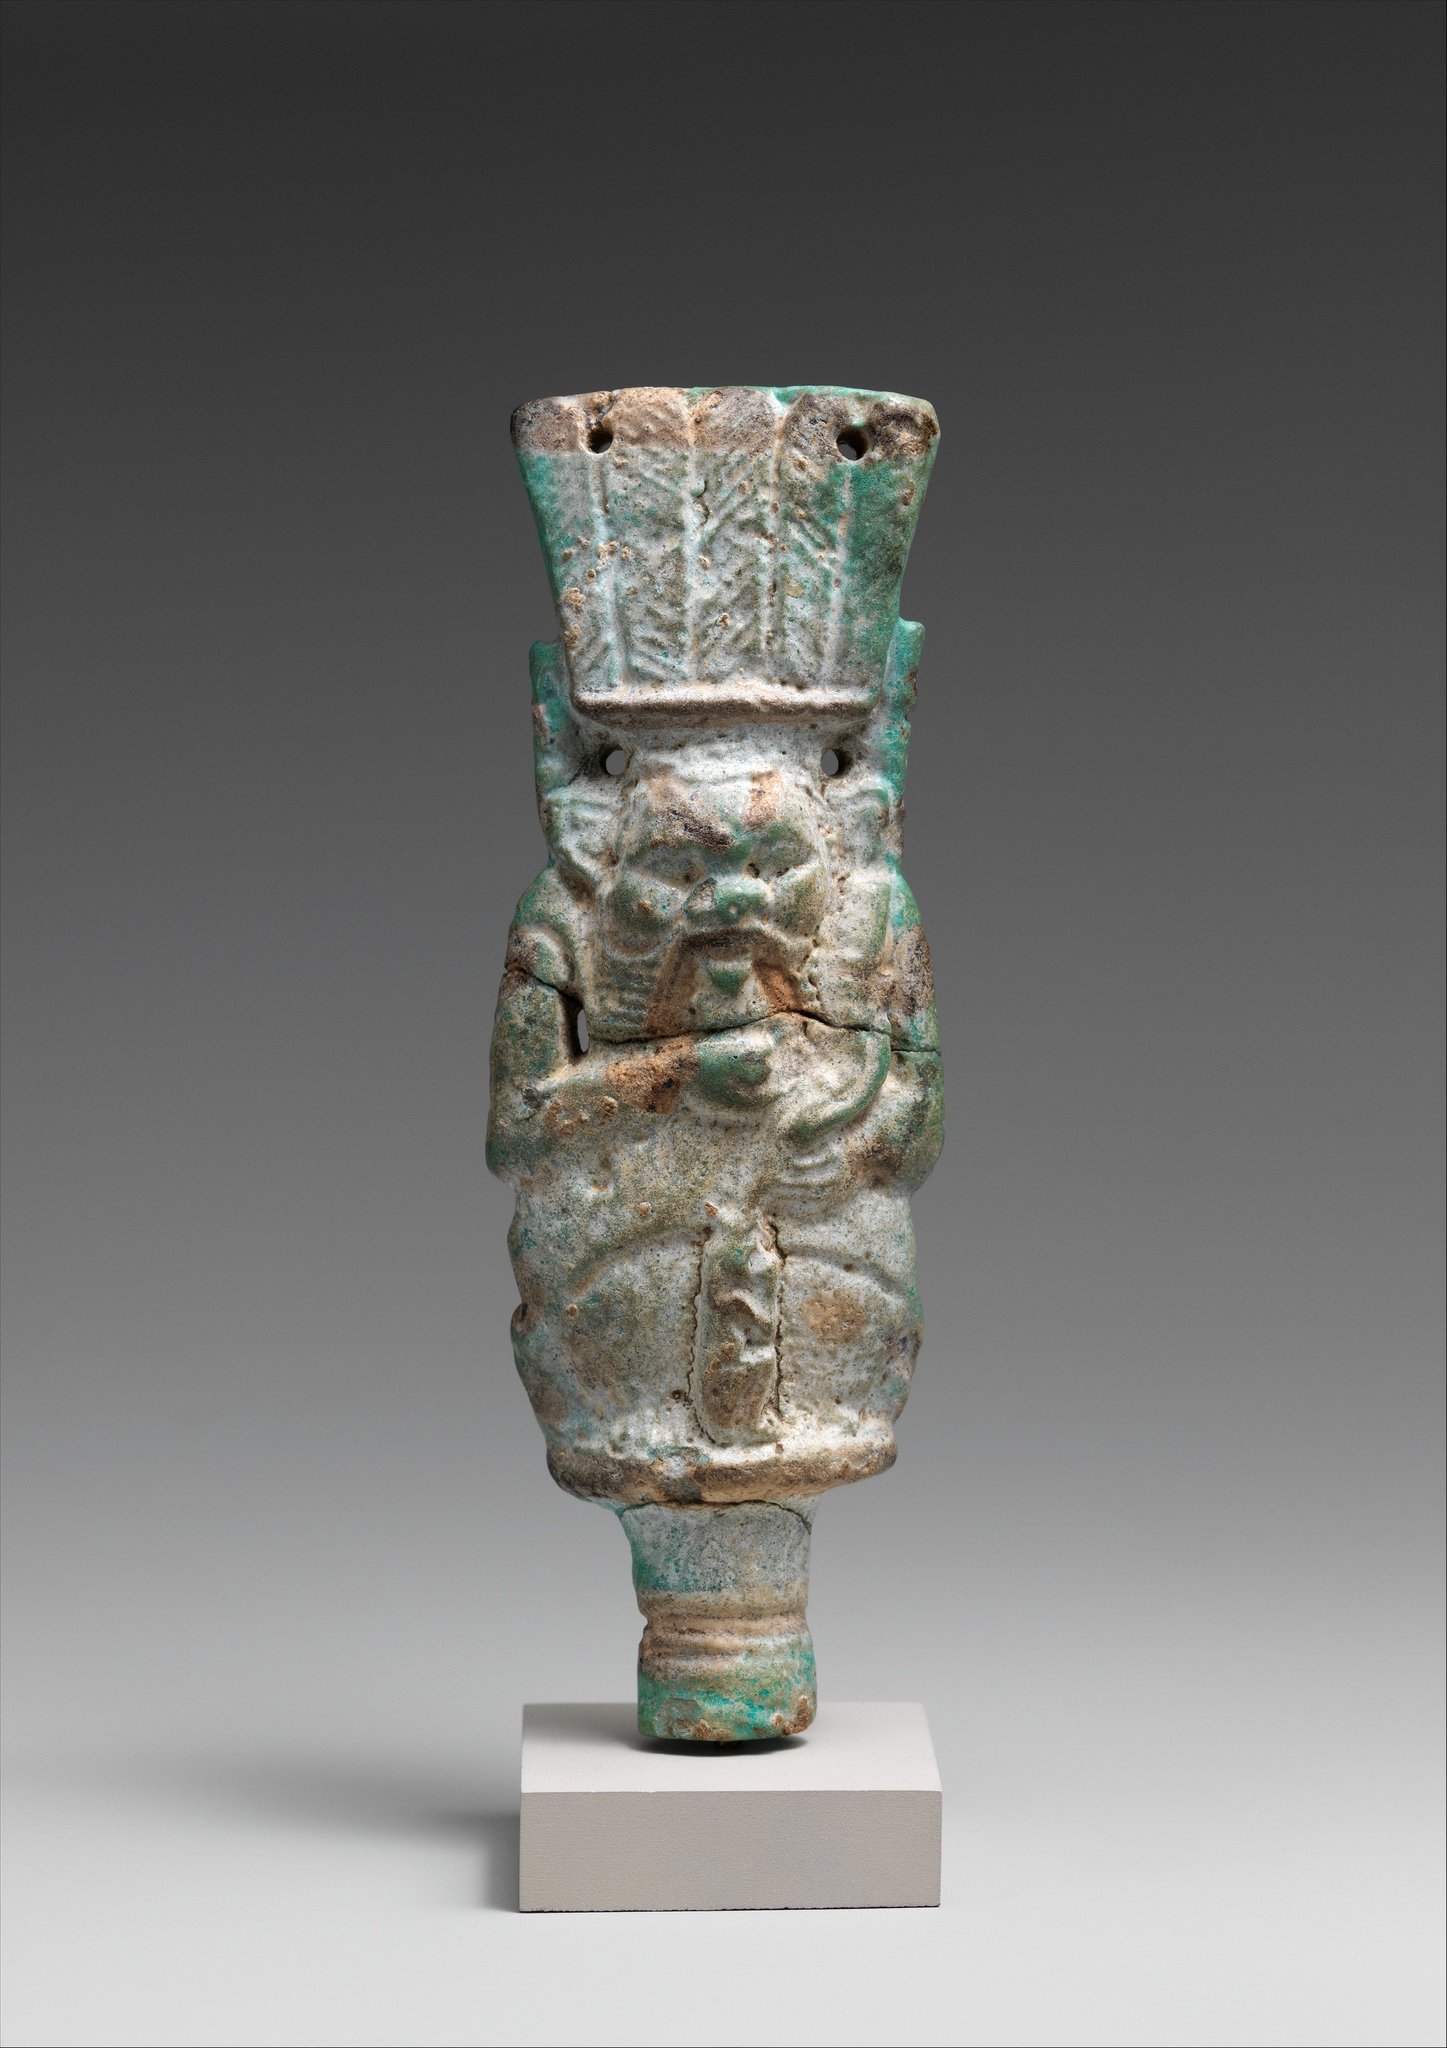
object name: statuette, be on finial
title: Bes with child on finial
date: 945-525 BCE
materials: faience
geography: egypt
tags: bes